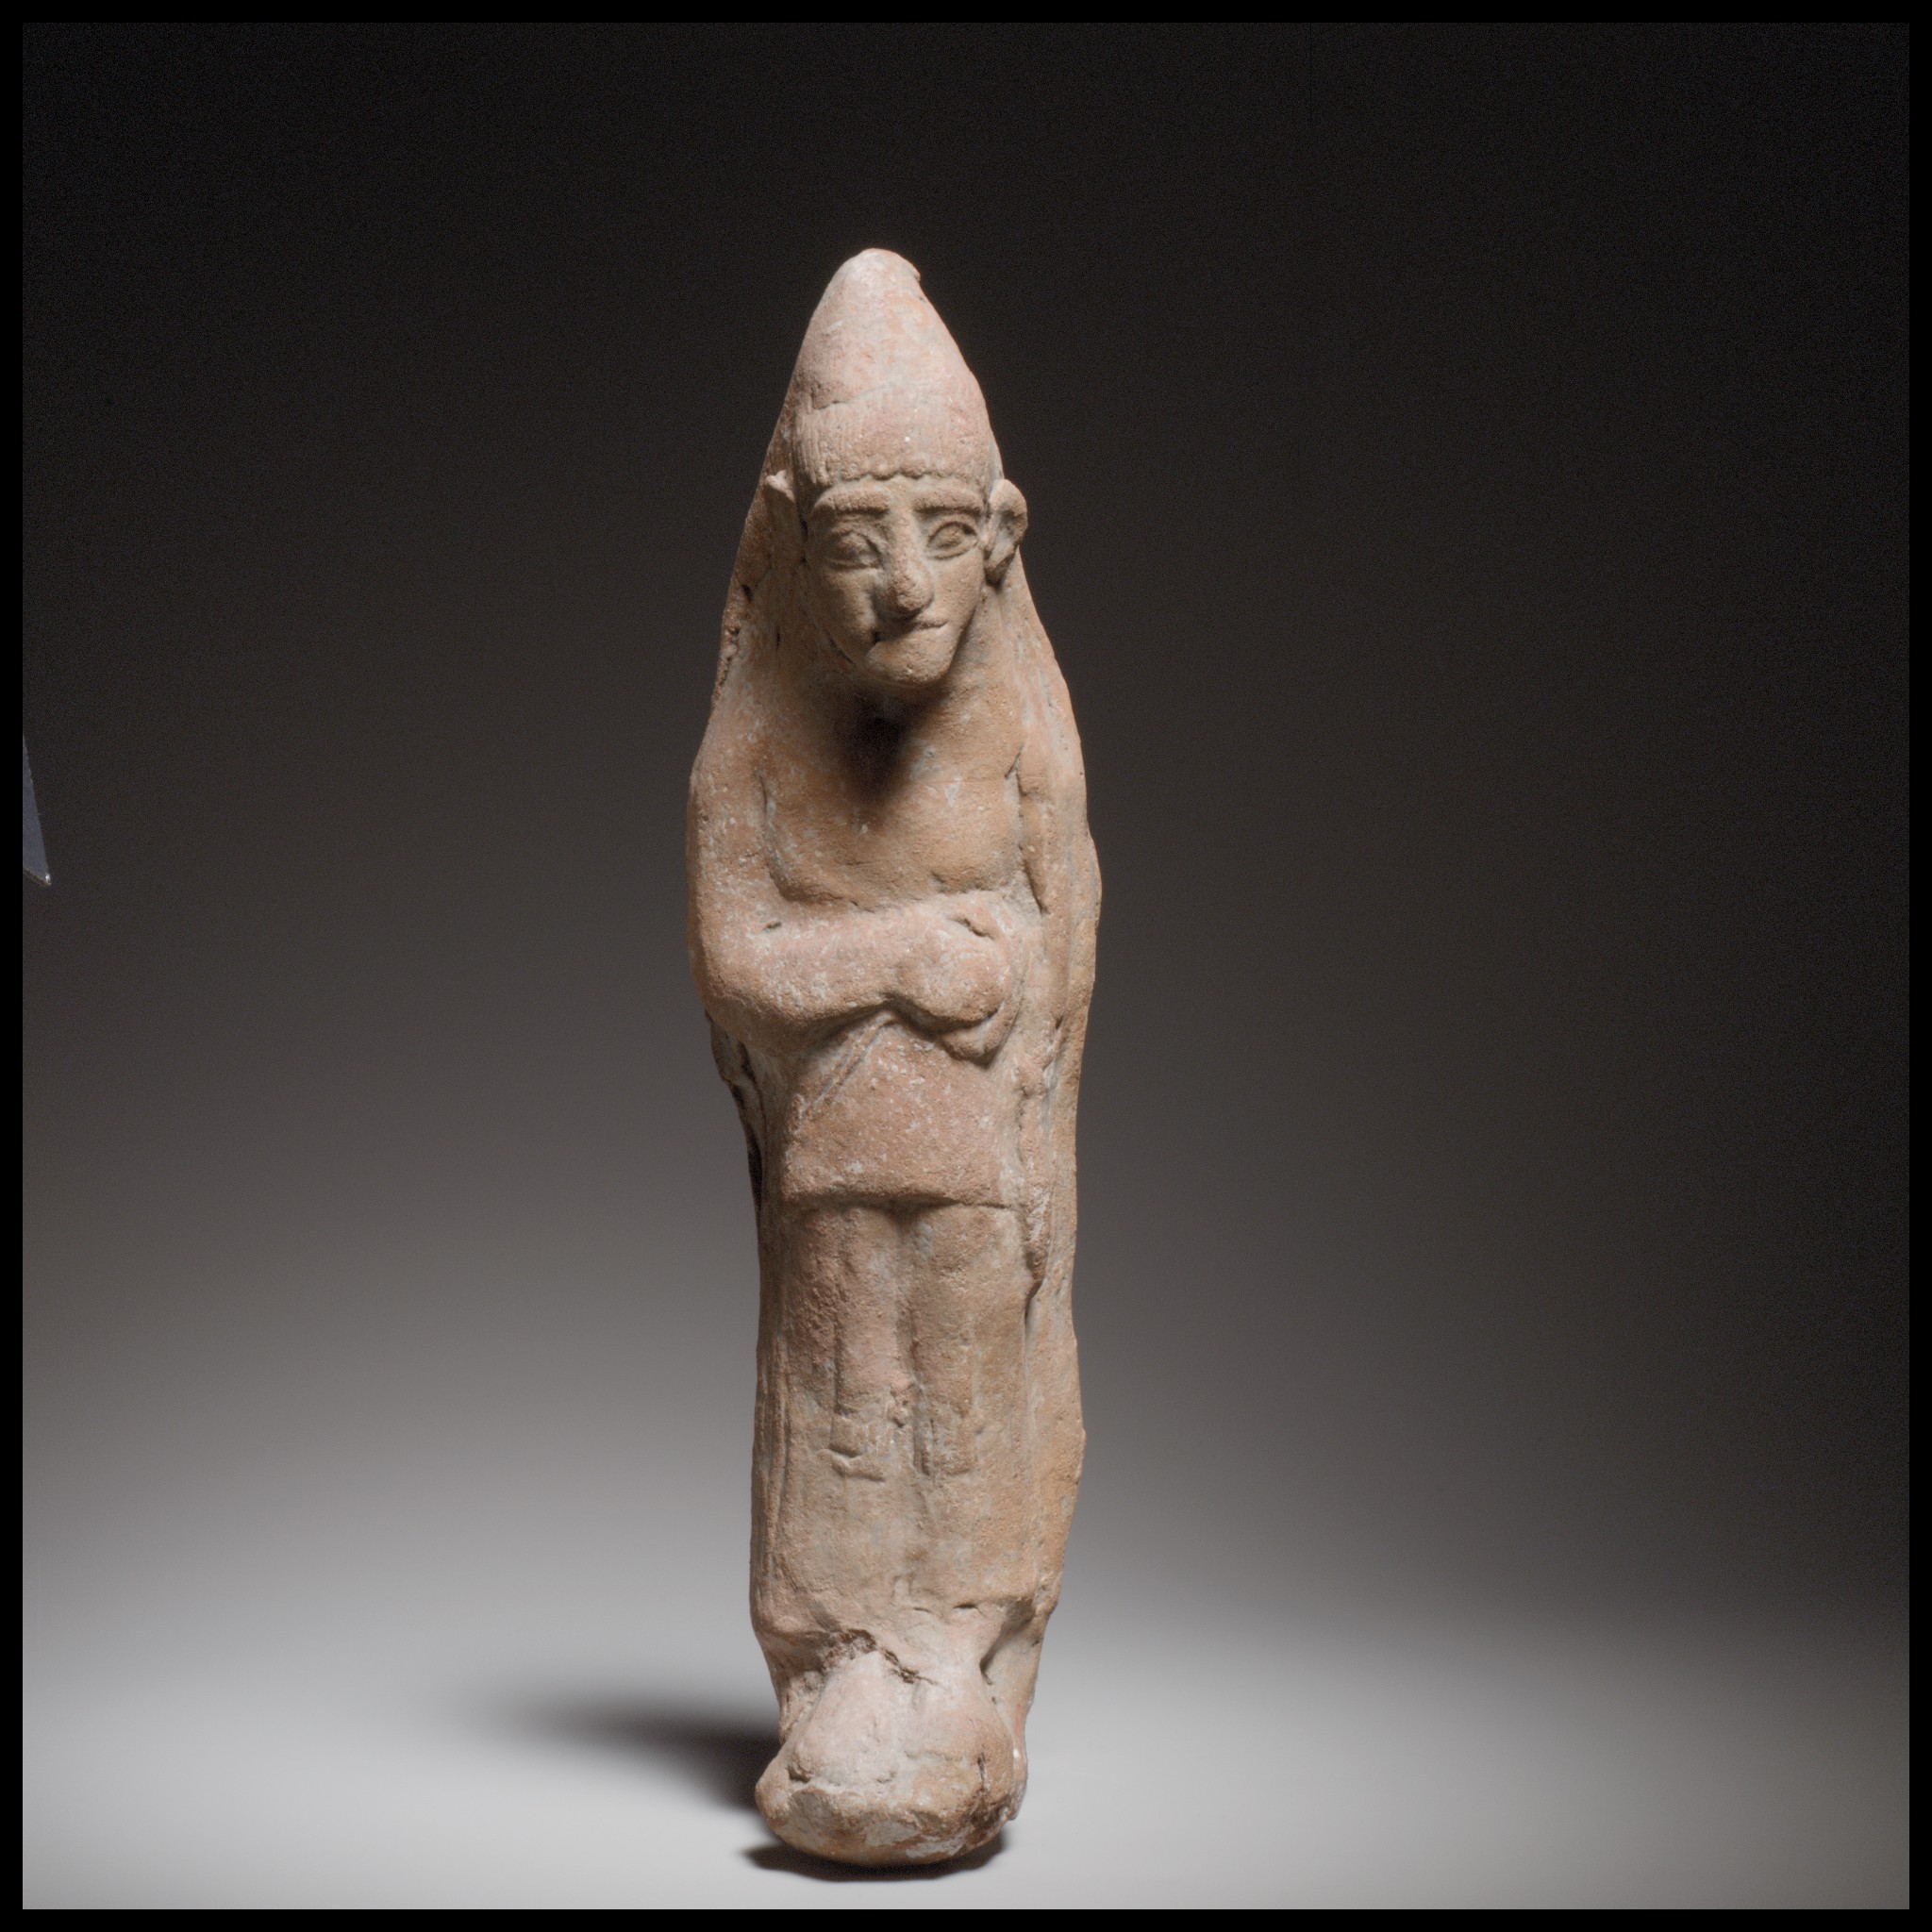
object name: statuette of a votary, male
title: Standing female figurine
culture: cypriot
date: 600-480 BCE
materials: terracotta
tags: women